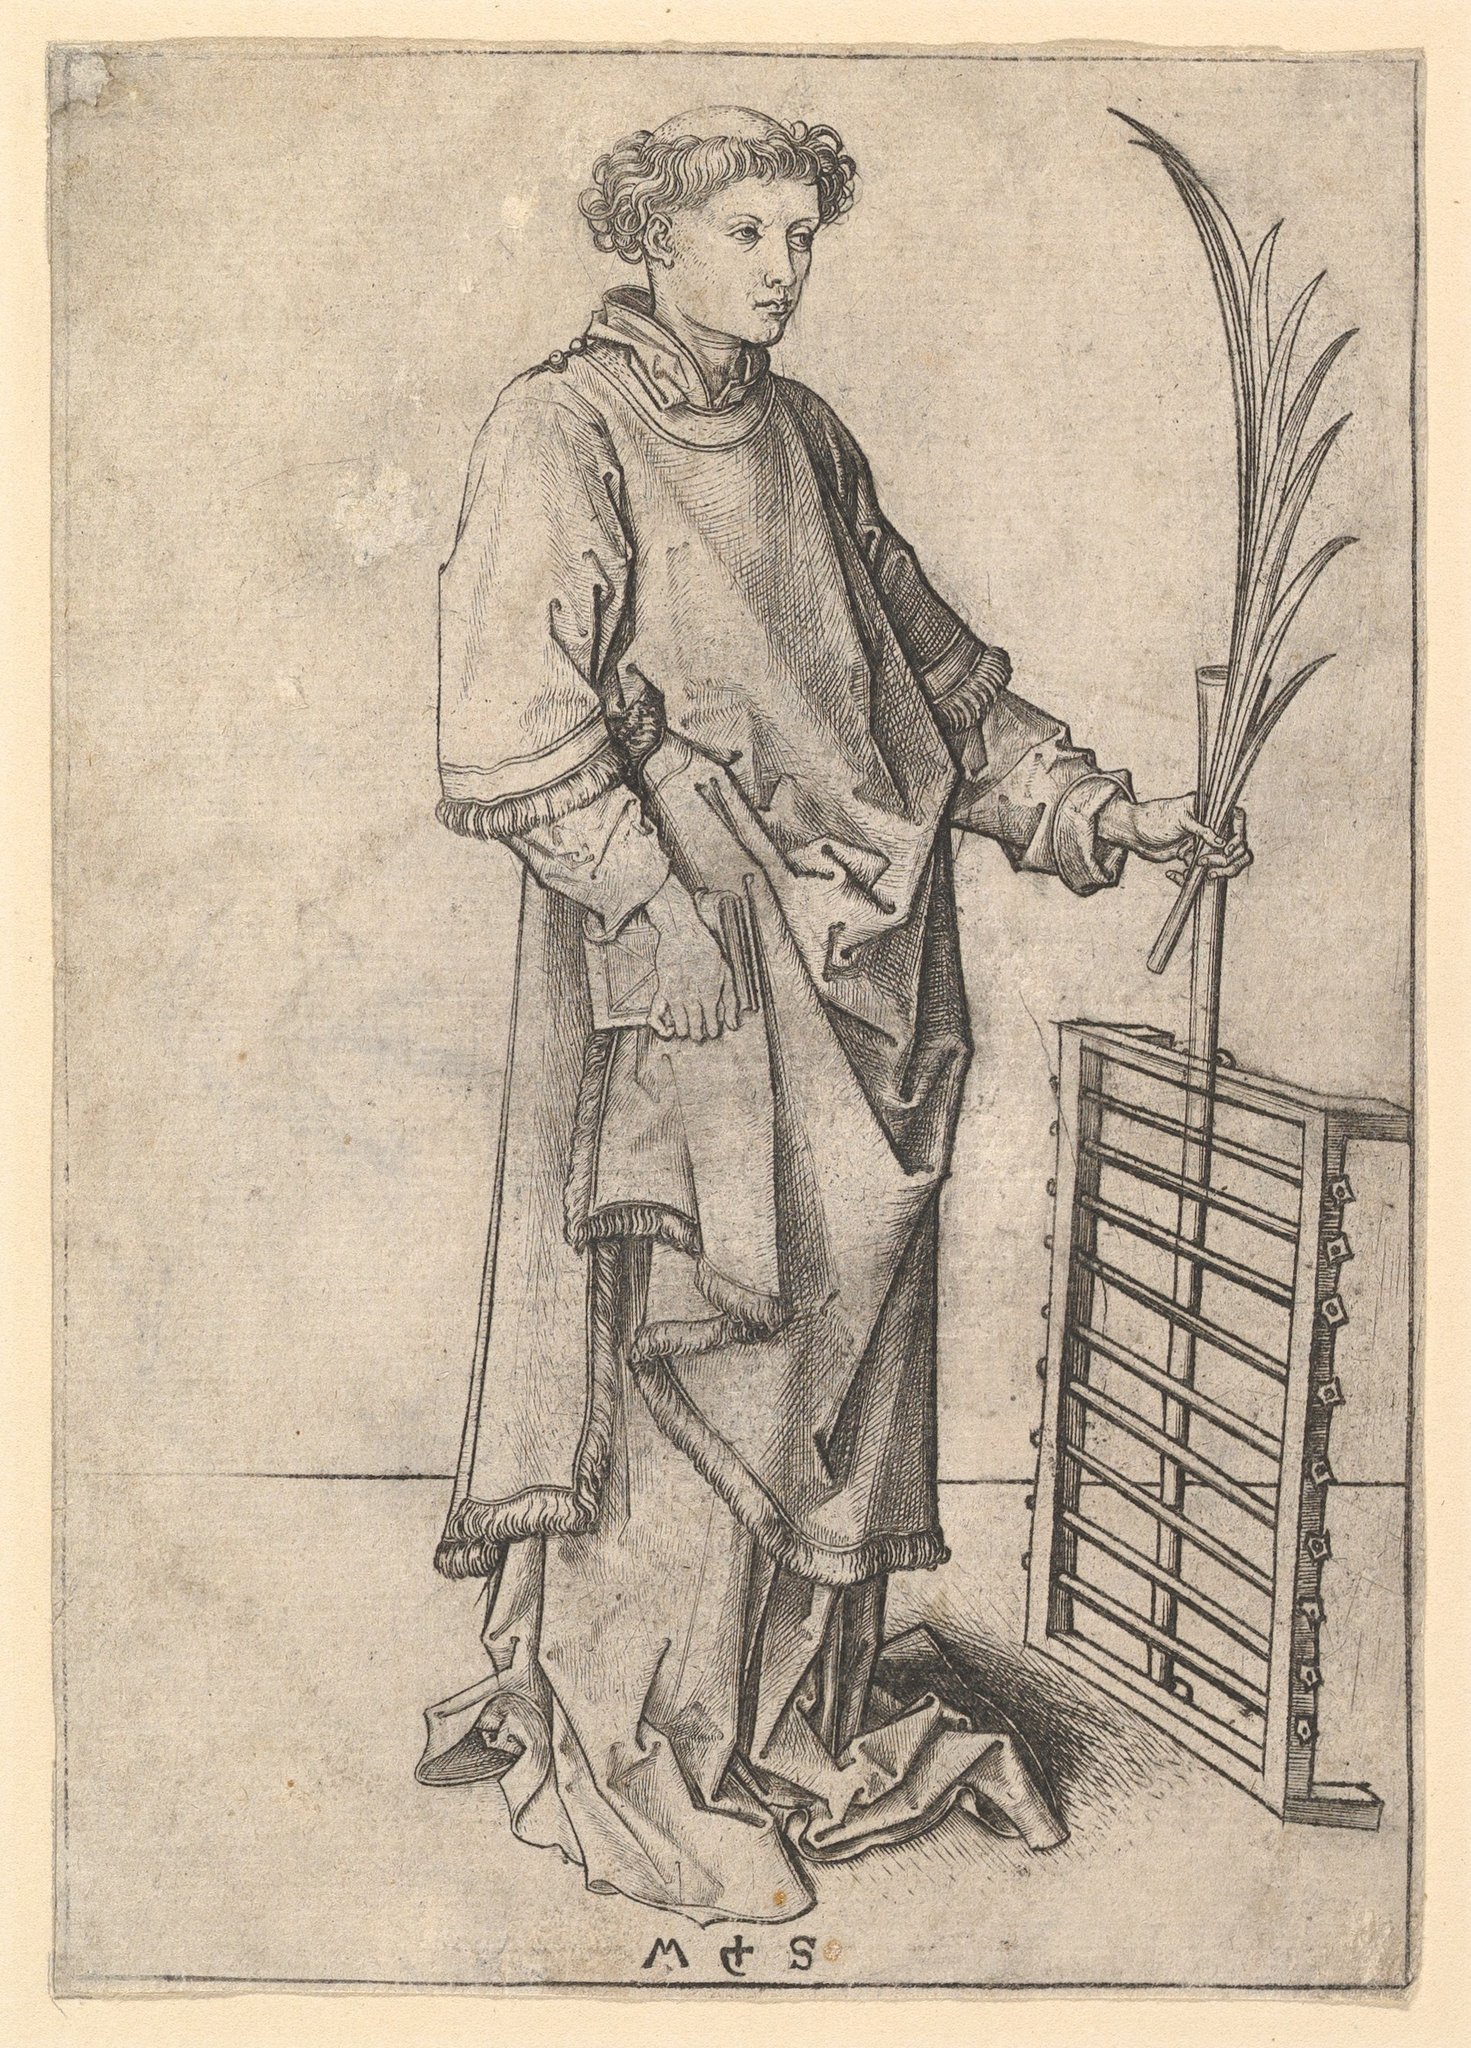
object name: print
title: St. Lawrence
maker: martin schongauer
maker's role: artist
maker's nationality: german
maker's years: 1430-1491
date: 1470-1491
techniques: engraving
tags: saint lawrence